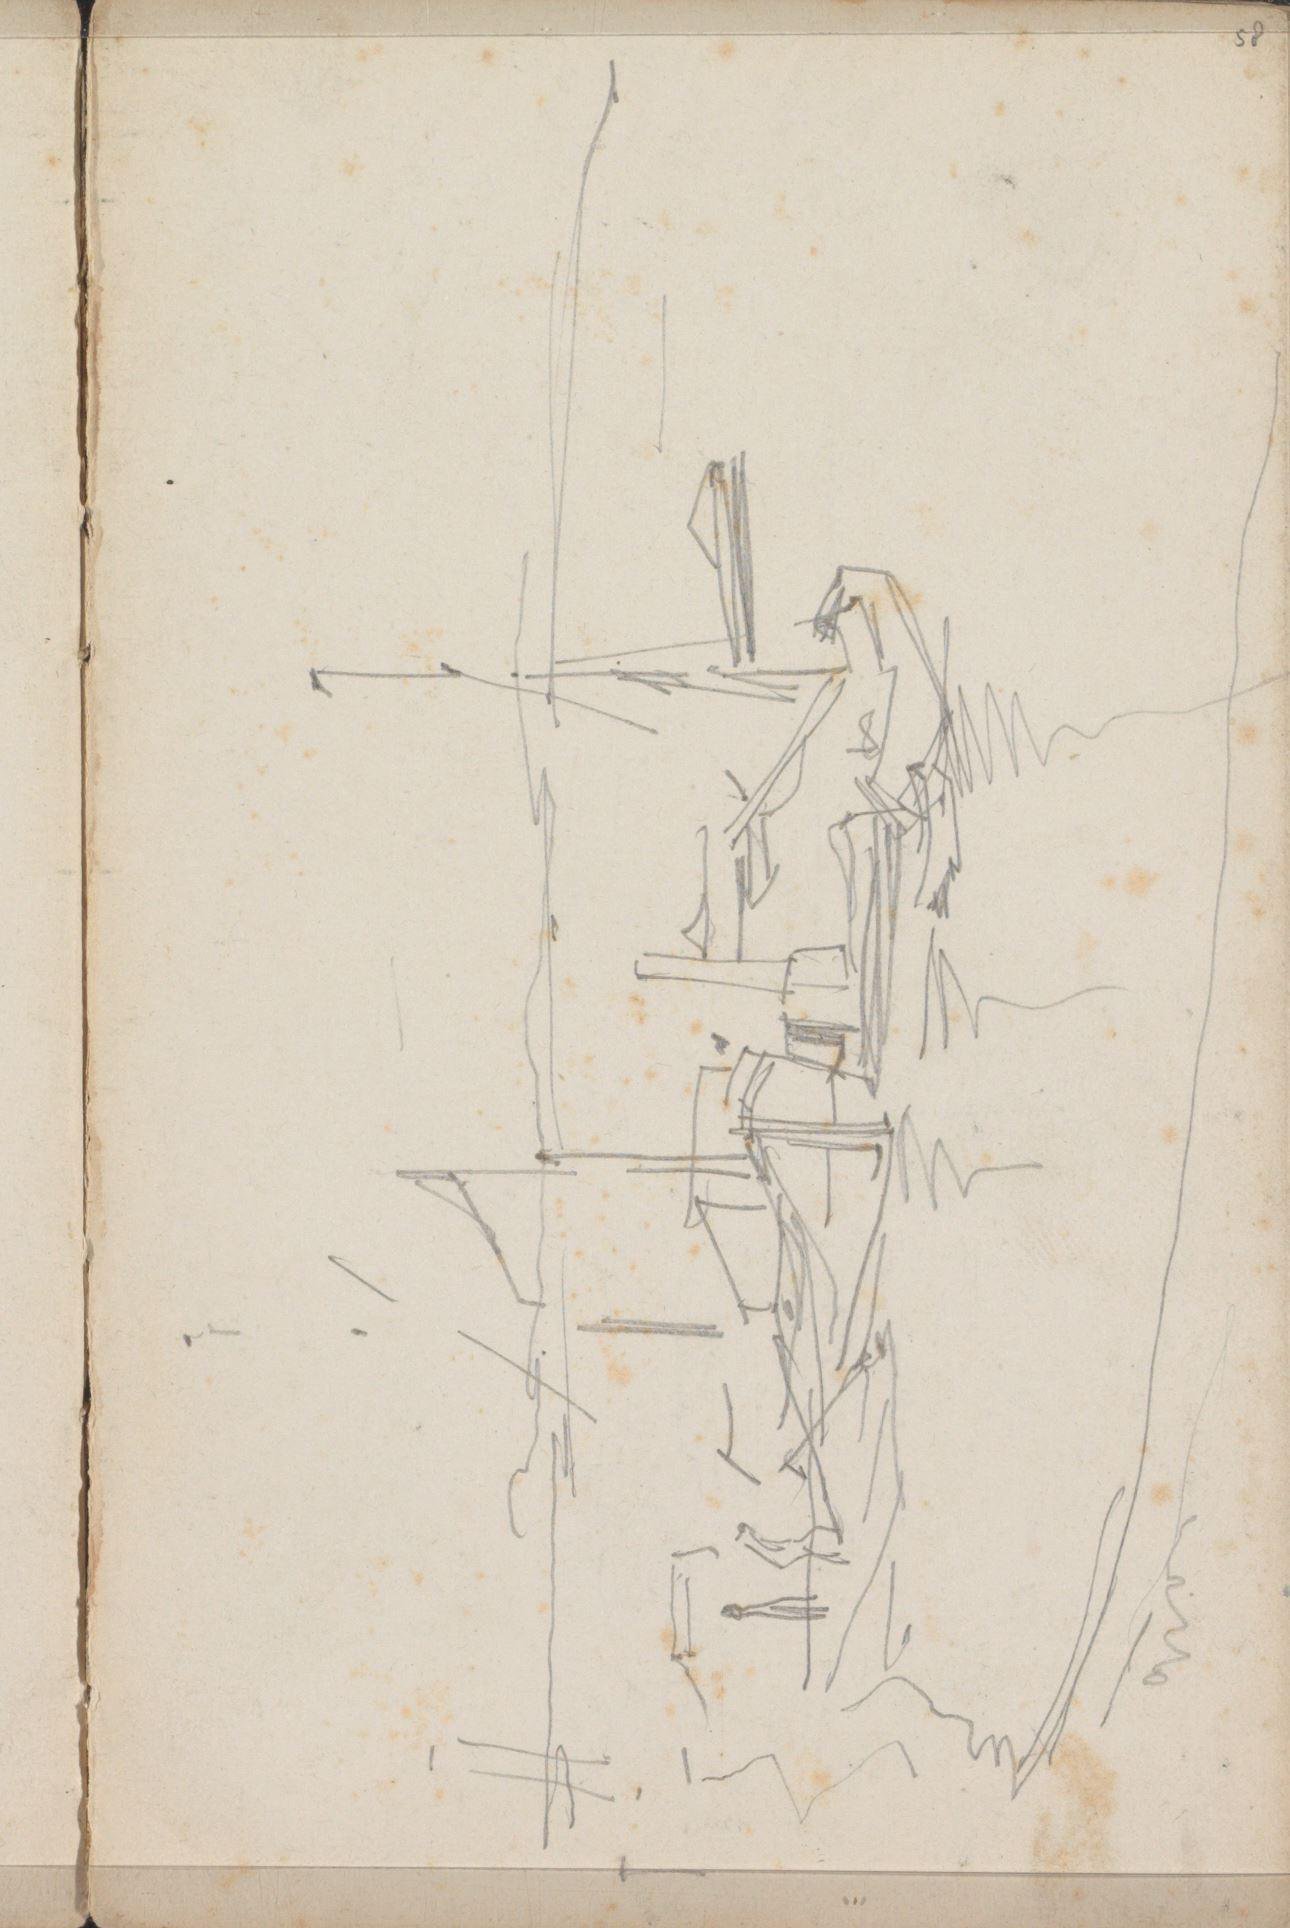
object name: sketchbook leaf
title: Aangemeerde boten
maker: george hendrik breitner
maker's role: draughtsman, painter, print maker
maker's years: 1857-1923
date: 1880-1882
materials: paper, pencil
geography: south holland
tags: landscapes with waters, waterscapes, seascapes (in the temperate zone), ships (in general)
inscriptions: kleurnotitie, handgeschreven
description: Pagina 58 uit een schetsboek met 72 bladen.